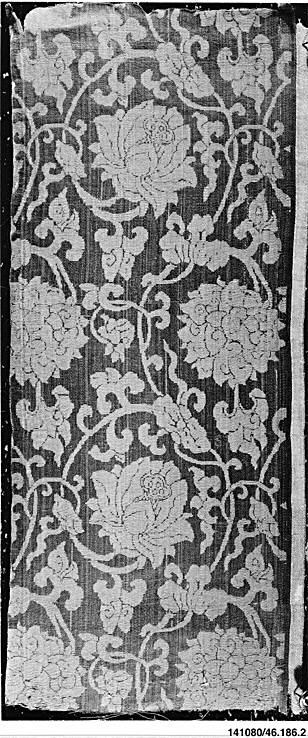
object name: sutra cover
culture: chinese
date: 1501-1700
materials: silk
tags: flowers